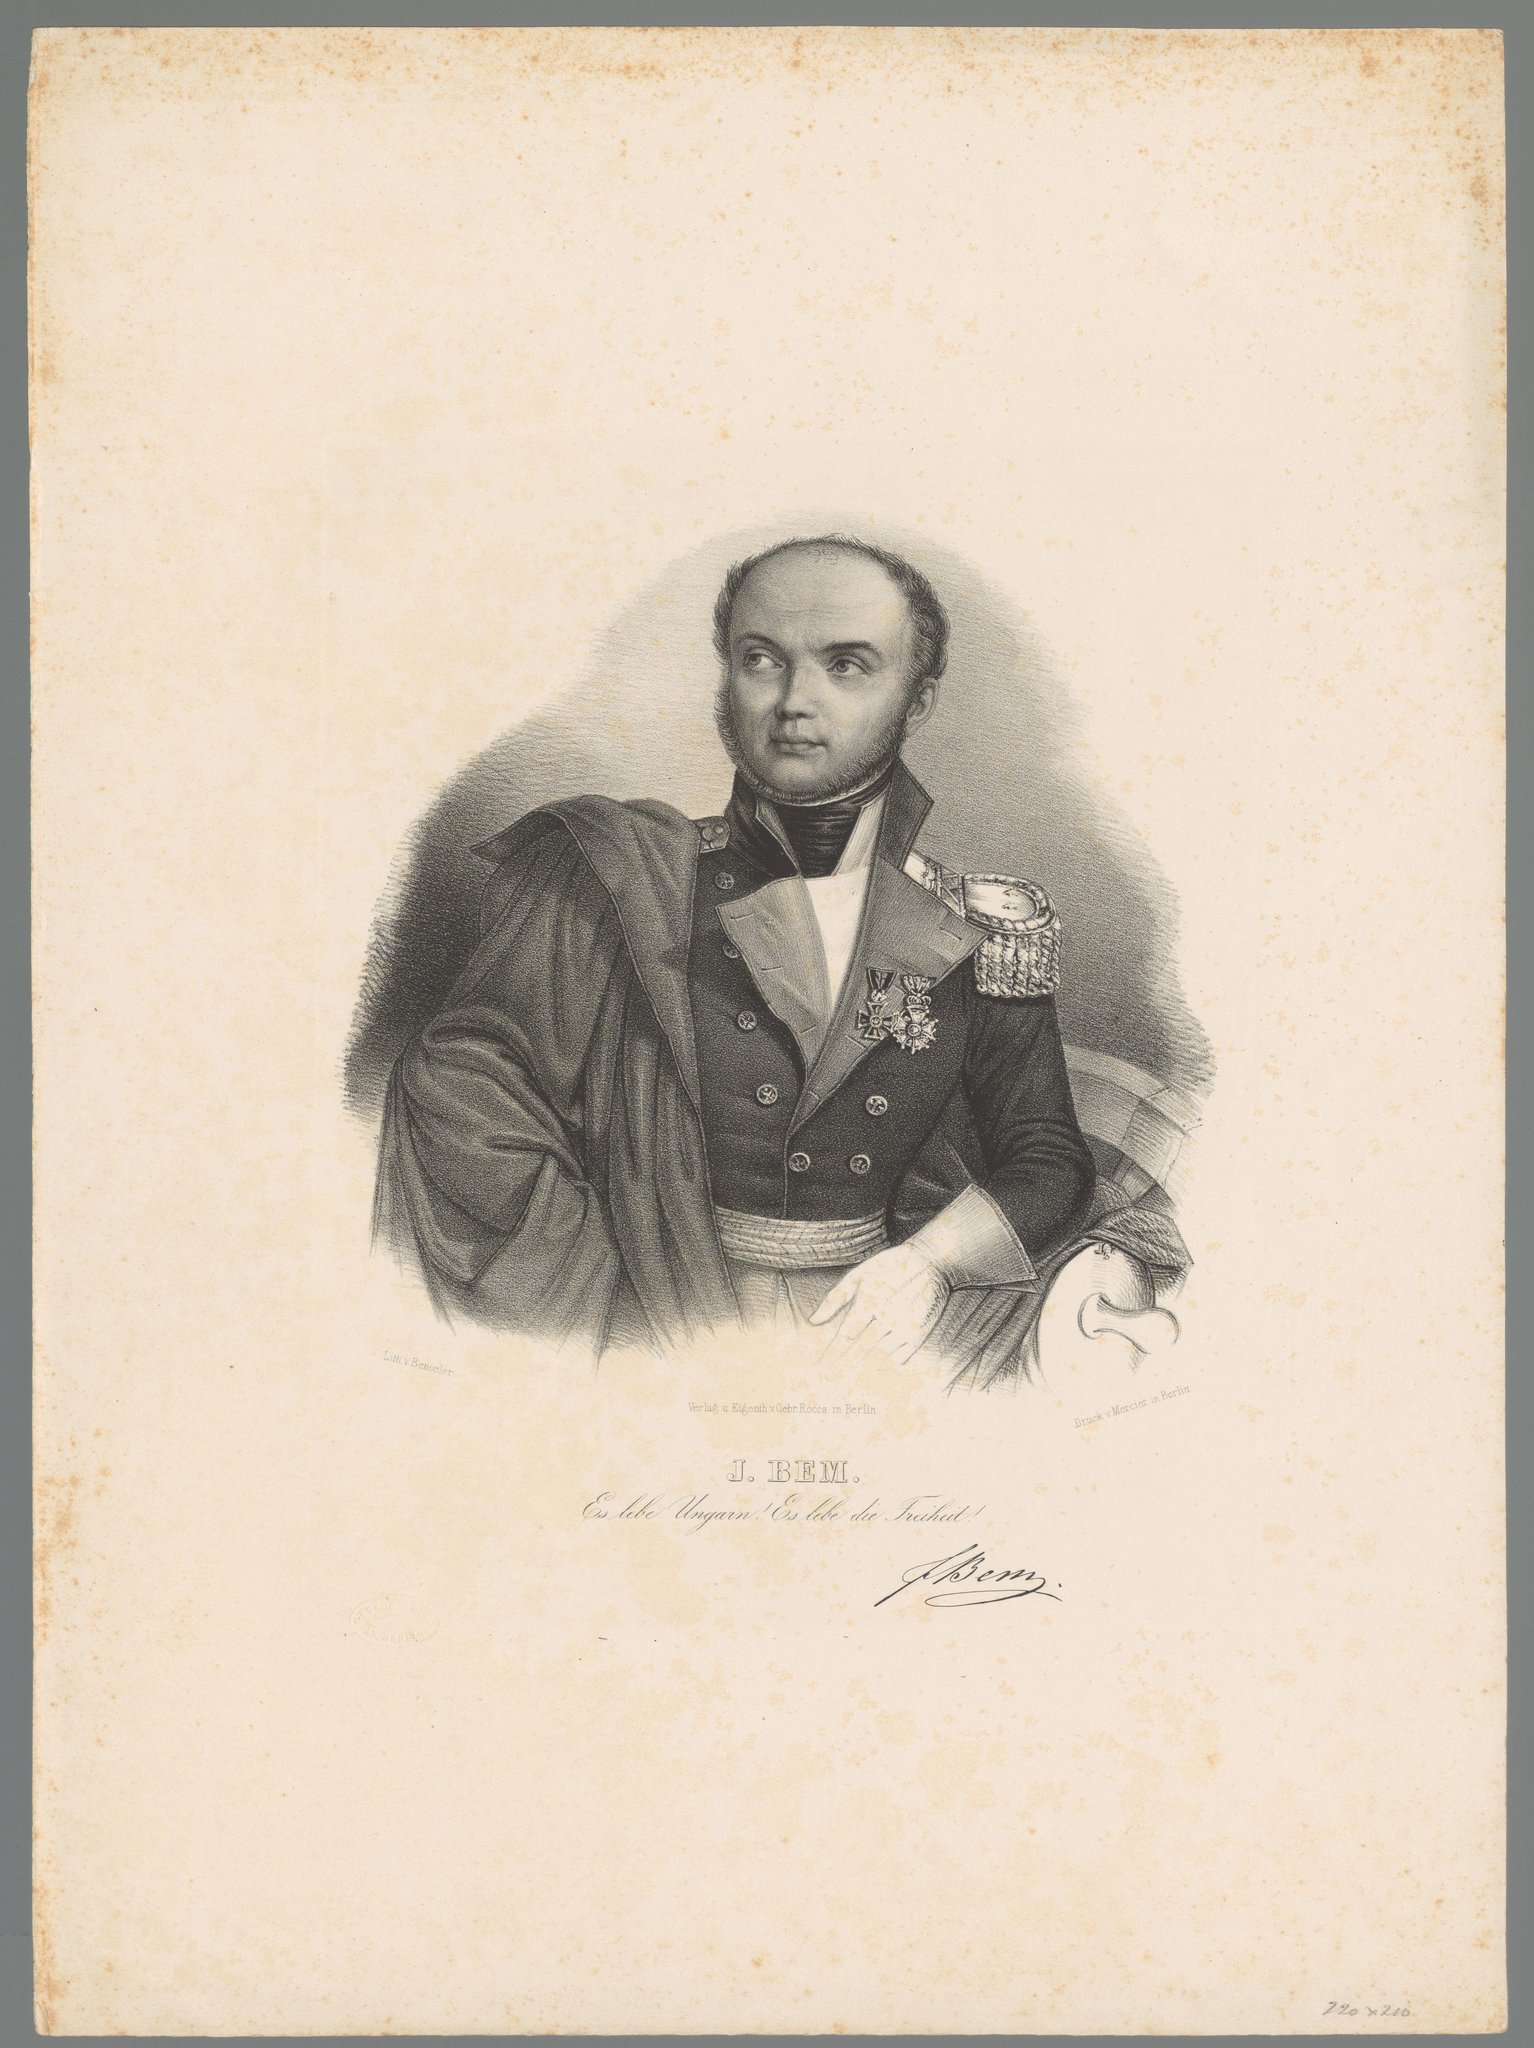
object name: print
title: J. Bem. Es lebe Ungarn! Es lebe die Freiheit!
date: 1850-1899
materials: paper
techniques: lithograph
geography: berlin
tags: engineer, adult man, historical persons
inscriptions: collector's mark: Lugt 2228, mark: Lugt 2141c